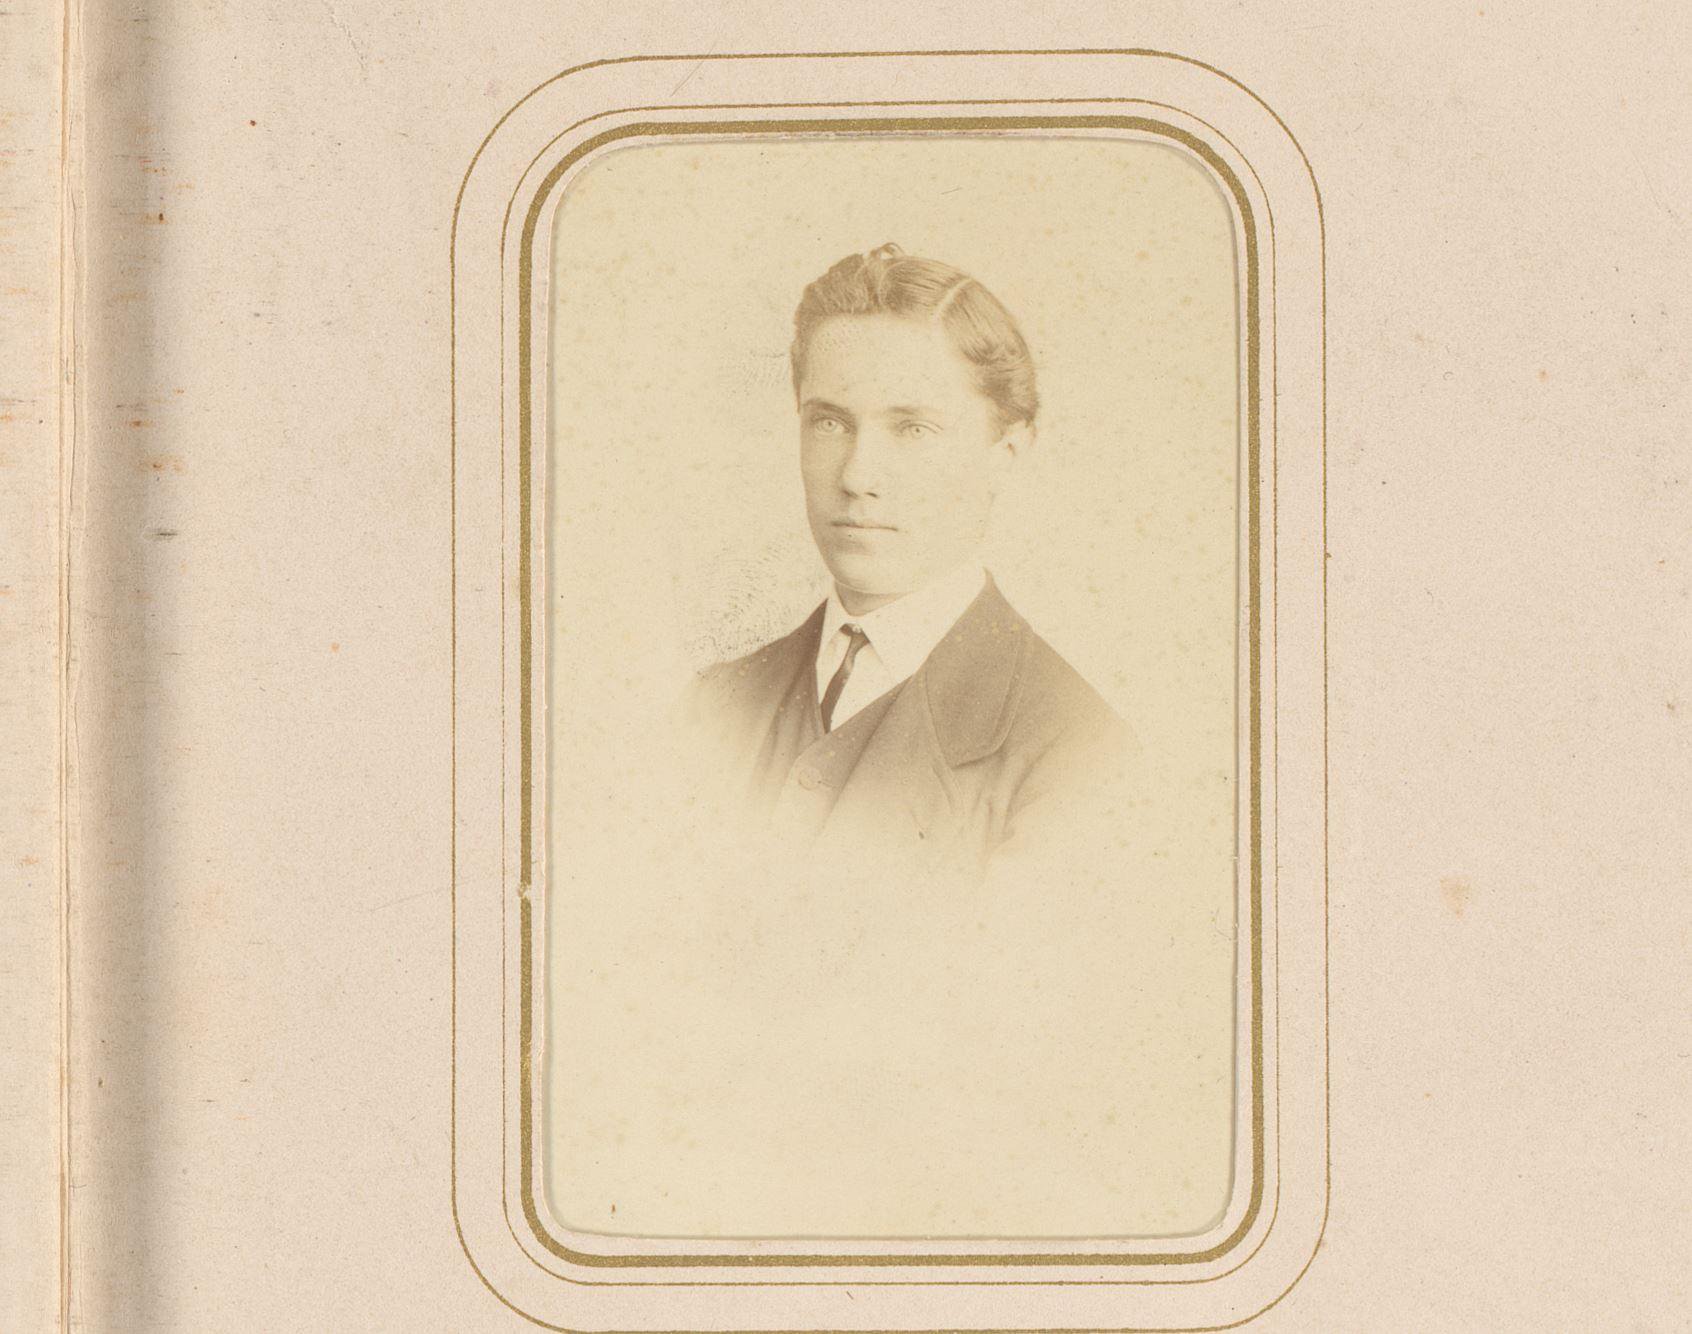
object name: photograph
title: Portret van een jonge man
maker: charles reutlinger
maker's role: publisher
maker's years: 1816-1880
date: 1850-1881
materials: cardboard, photographic support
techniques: albumen print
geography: paris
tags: historical persons, youth, adolescent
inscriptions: inscription: ‘CH. REUTLINGER,/ PHOTOGRAPHE/ 21, Boulevart Montmartre, 21/ ET/ 112, Rue Richelieu, 112/ PARIS/ Les Clichés étant conservés indéfiniment,/ on peut toujours se procurer de nouvelles/ épreuves de Cartes & Portraits sans reposer’